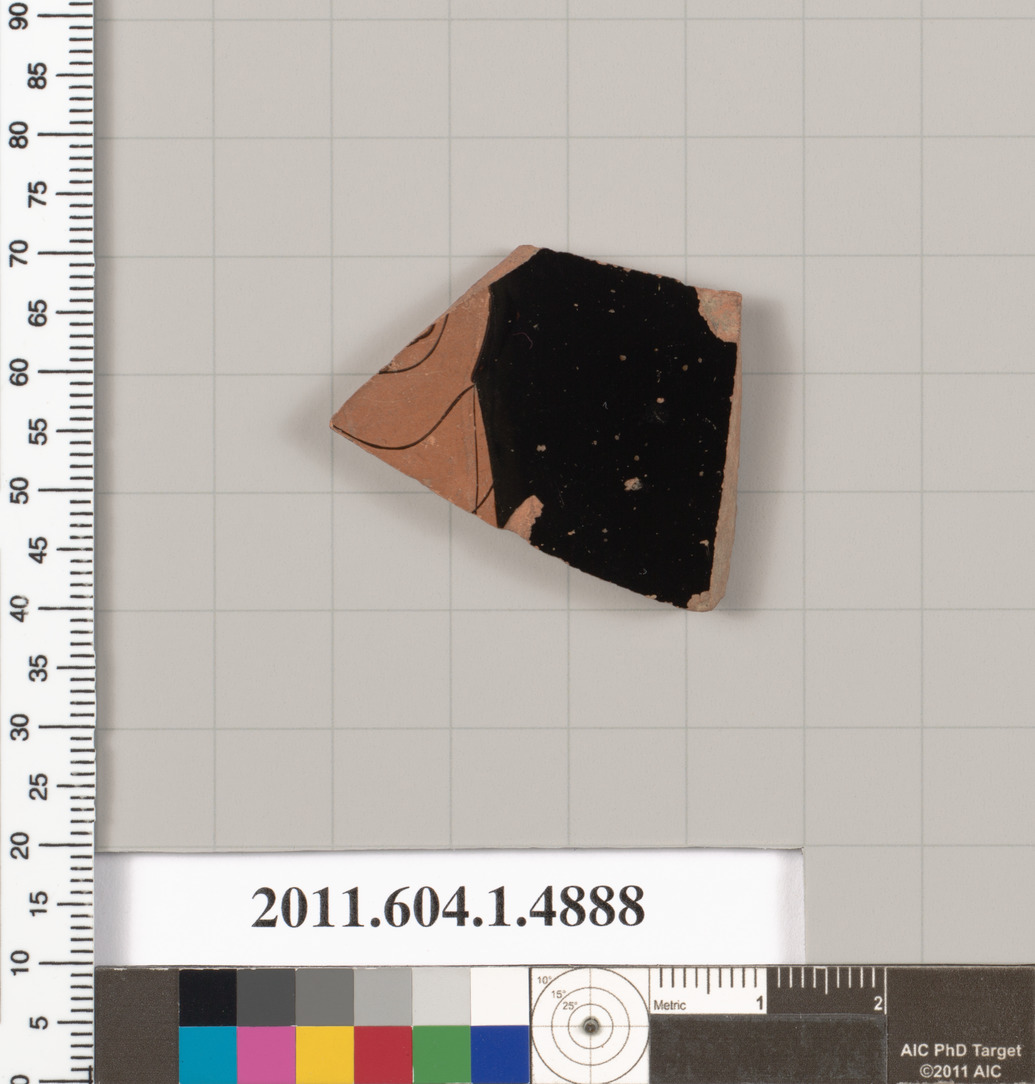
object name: kylix fragment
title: Terracotta fragment of a kylix (drinking cup)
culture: greek, attic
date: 480-470 BCE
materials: terracotta